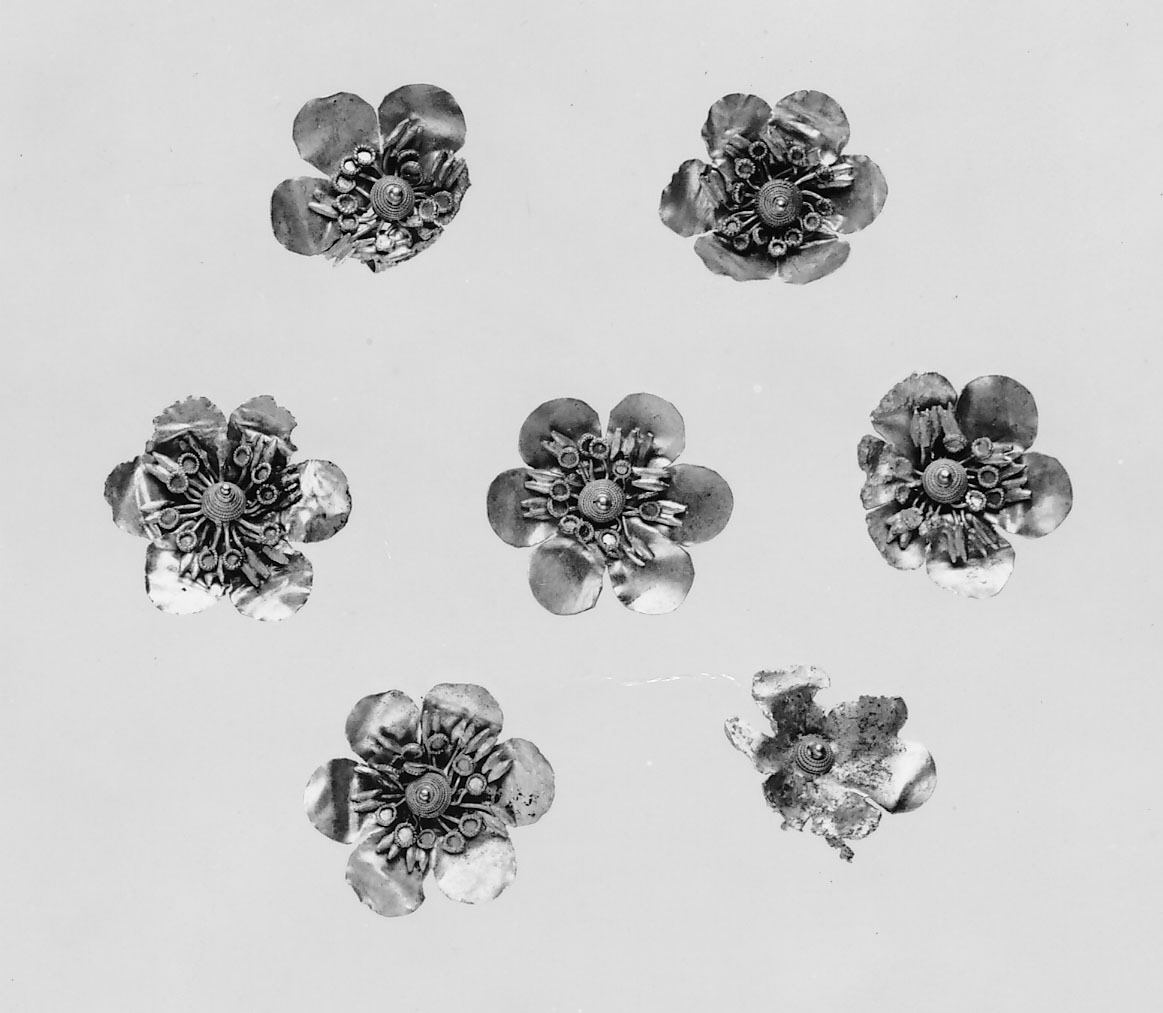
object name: bead ornament, rosette, 7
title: Seven gold rosettes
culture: greek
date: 330-300 BCE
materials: gold